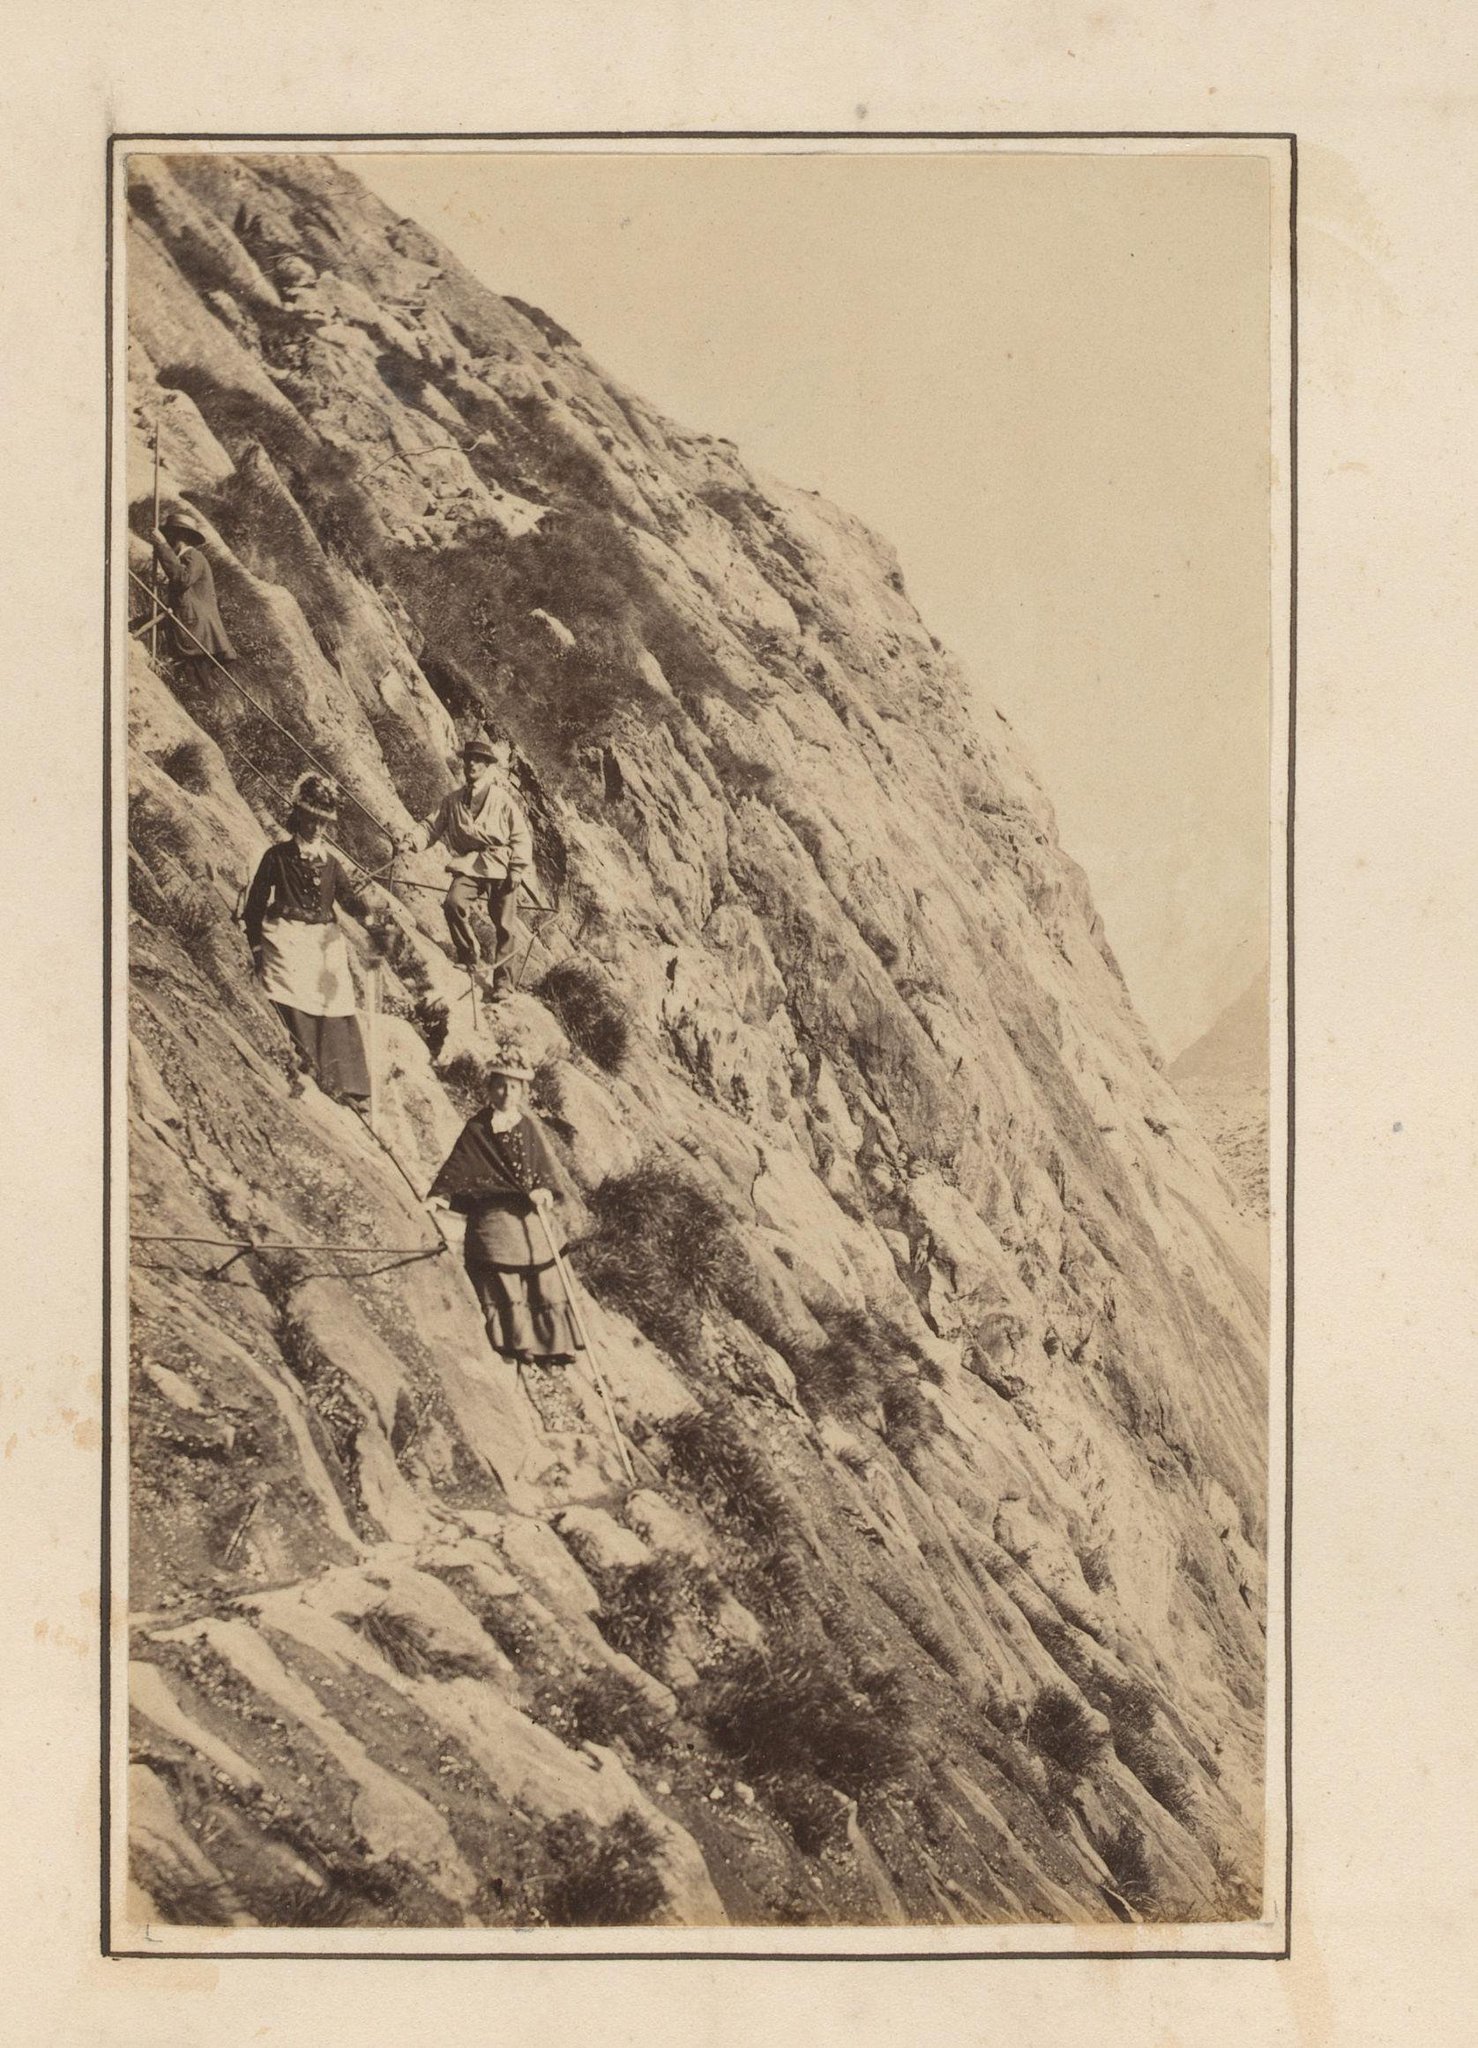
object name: photograph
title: Hôtel sur le Montainvert et l'Aguille du Dru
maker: Anonymous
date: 1870-1890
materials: paper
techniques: albumen print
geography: mer de glace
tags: mountain-top, peak, hotel, hostelry, inn